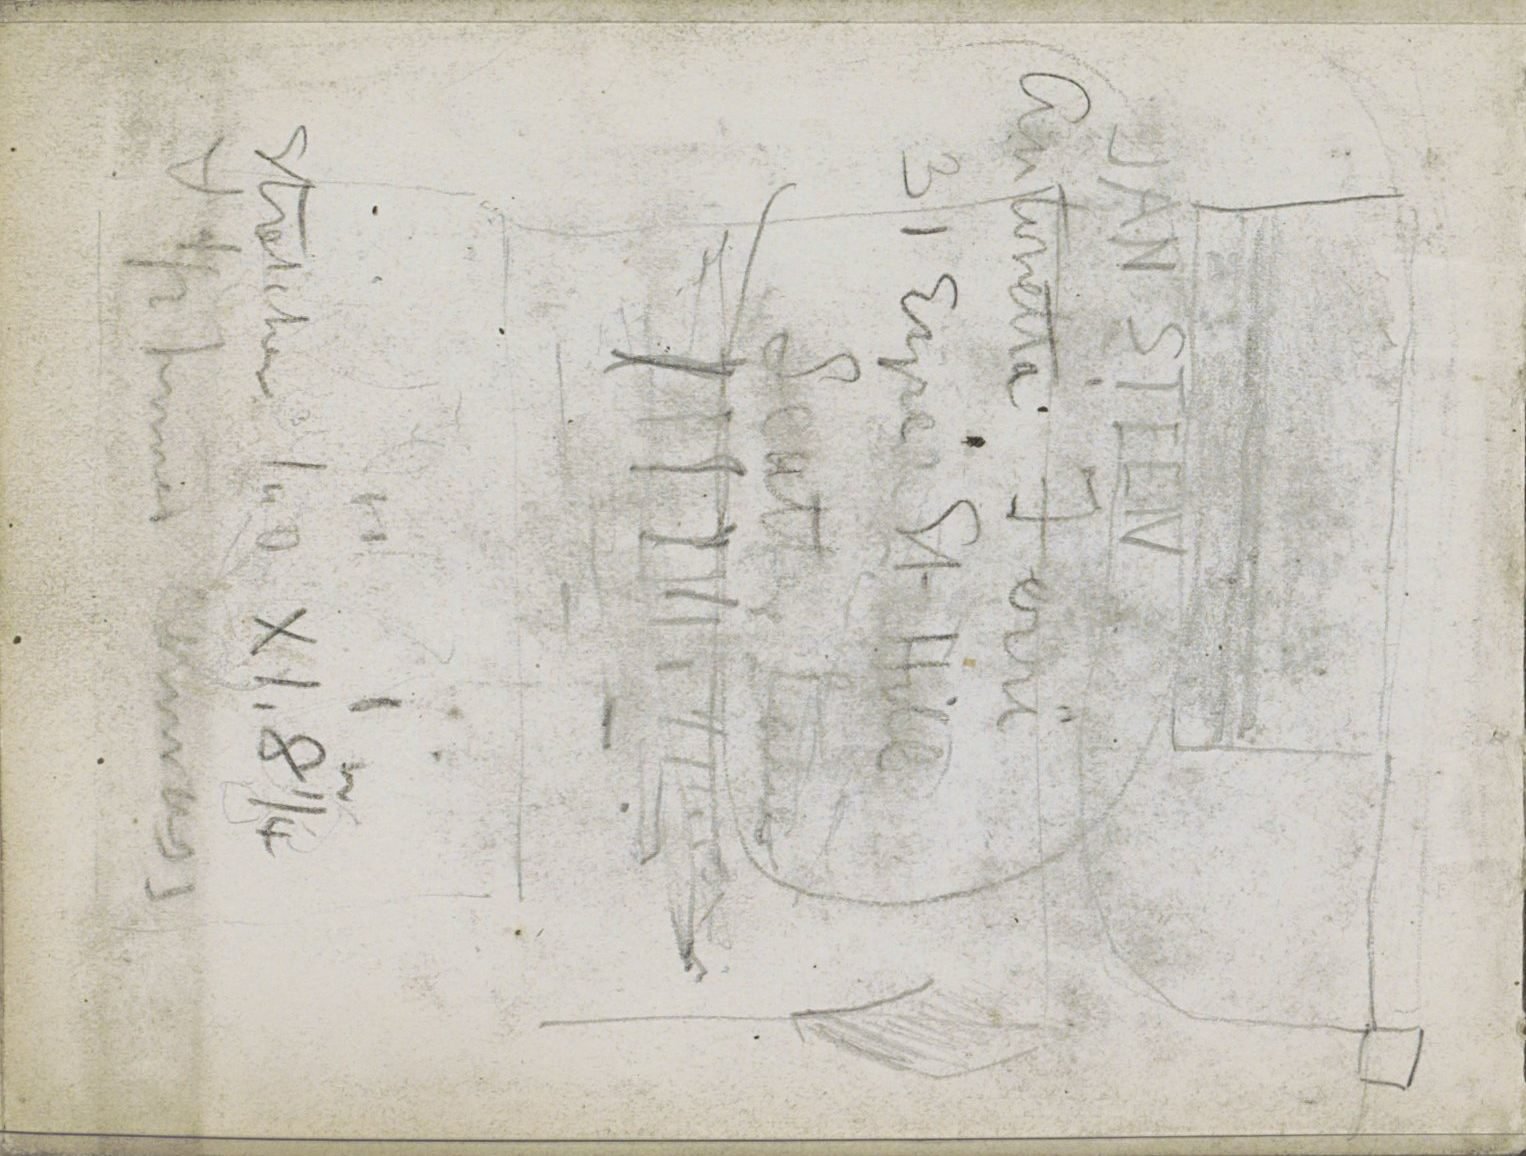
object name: sketchbook leaf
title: Notities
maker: george clausen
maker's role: draughtsman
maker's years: 1852-1912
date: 1874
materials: chalk, paper, pencil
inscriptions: annotation: ‘JAN STEEN/ Antonetta I erri/ 31 Eyre St Hill/ Scott Lane/ stretcher 140 x 1.81/4/ [...]1/2 [...]’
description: Blad 37 verso uit een schetsboek met 37 bladen.